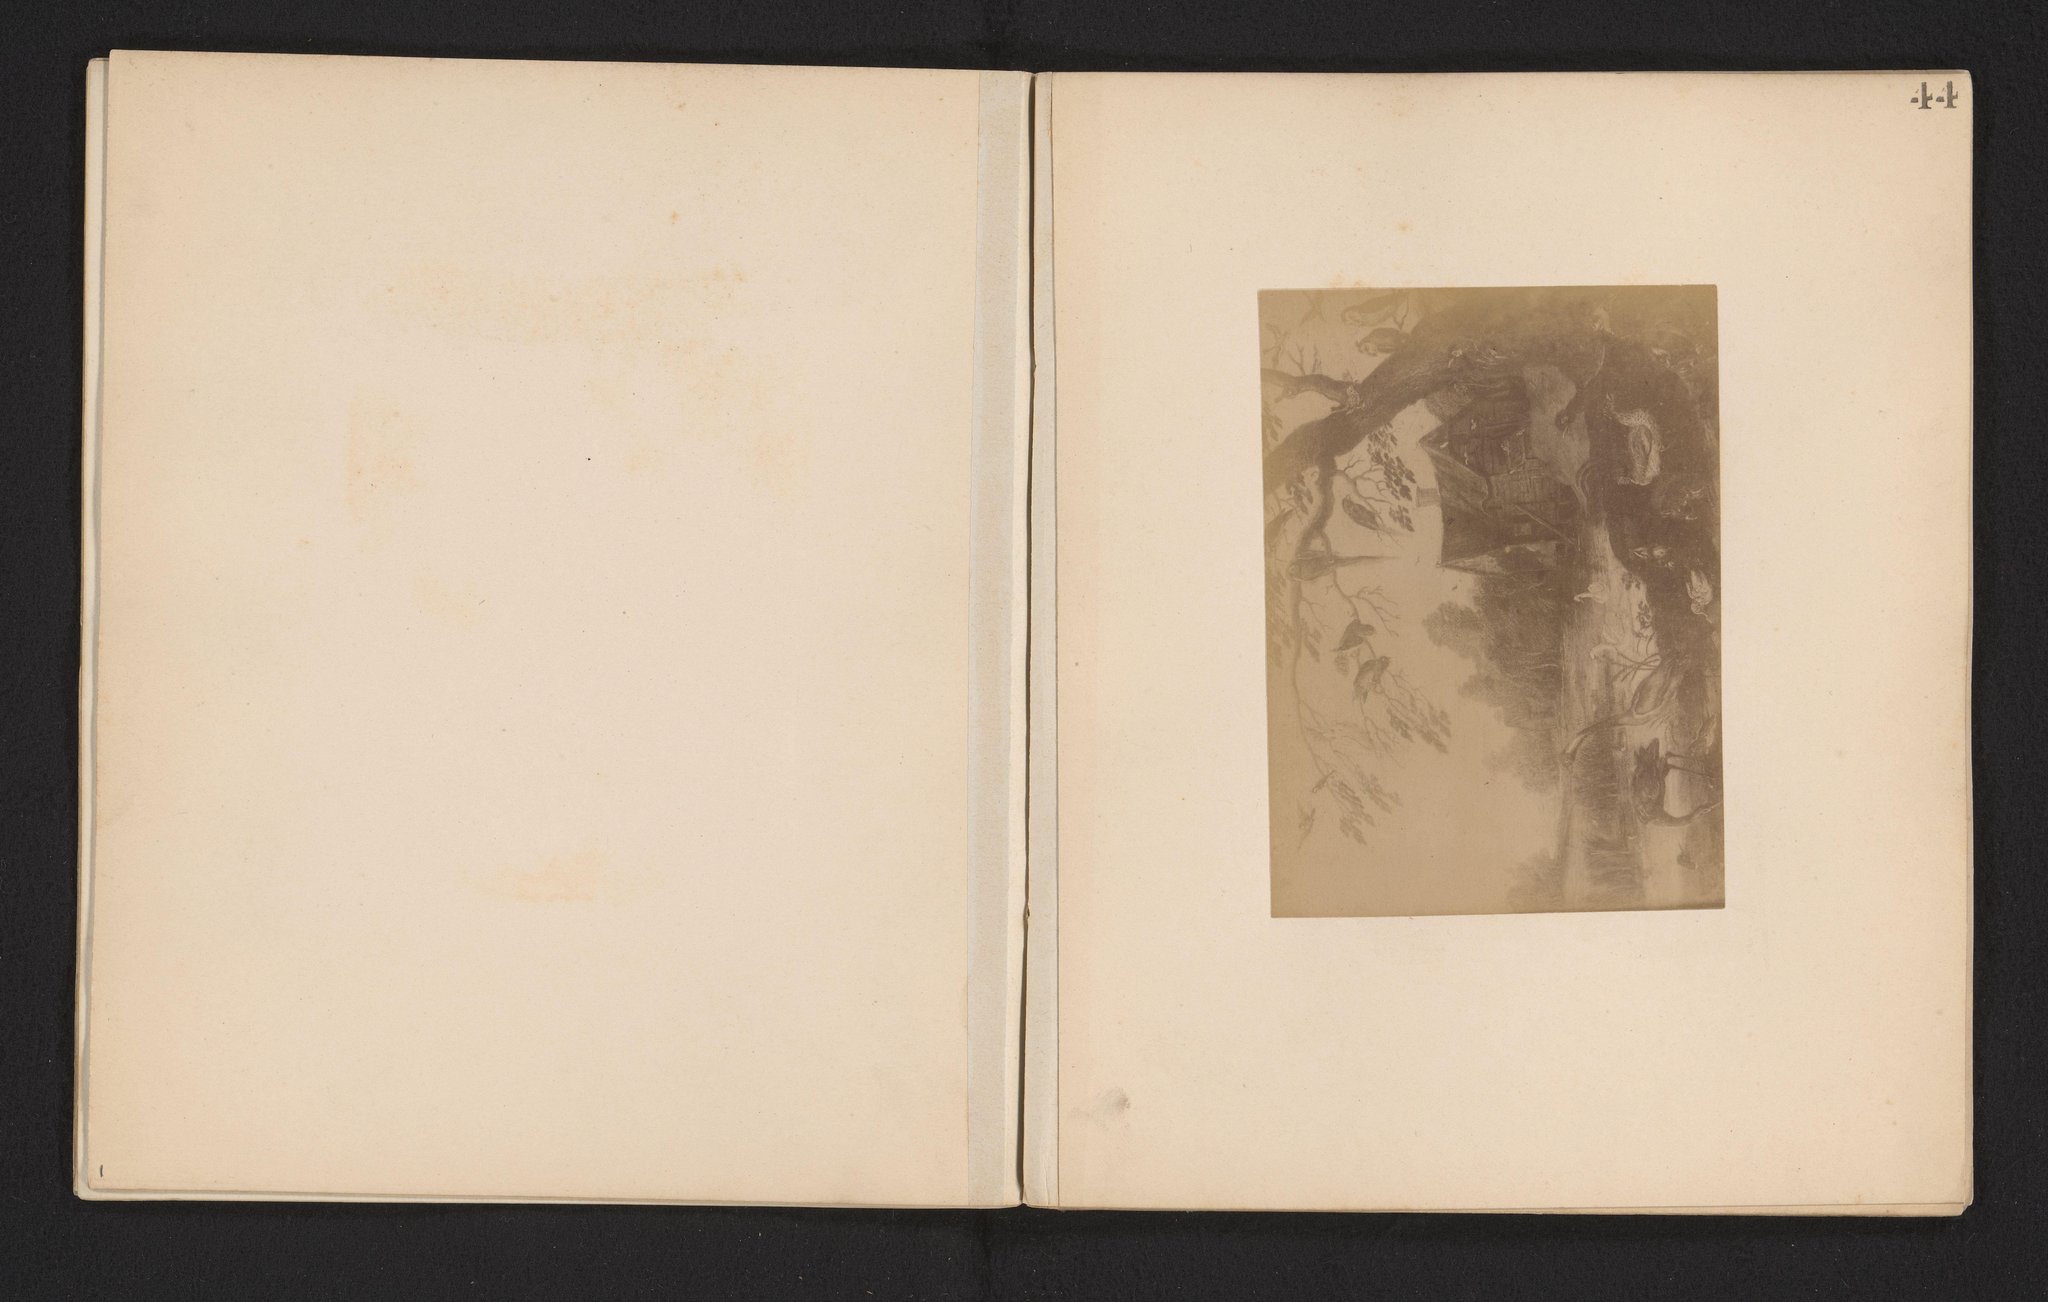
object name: page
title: Fotoreproductie van een schilderij van een landschap met dieren door Jan van Kessel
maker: Anonymous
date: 1882-1887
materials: photographic support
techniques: albumen print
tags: landscapes (+ landscape with figures, staffage)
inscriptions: number: ‘44’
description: Foto op derde ongenummerde pagina na pagina 16.